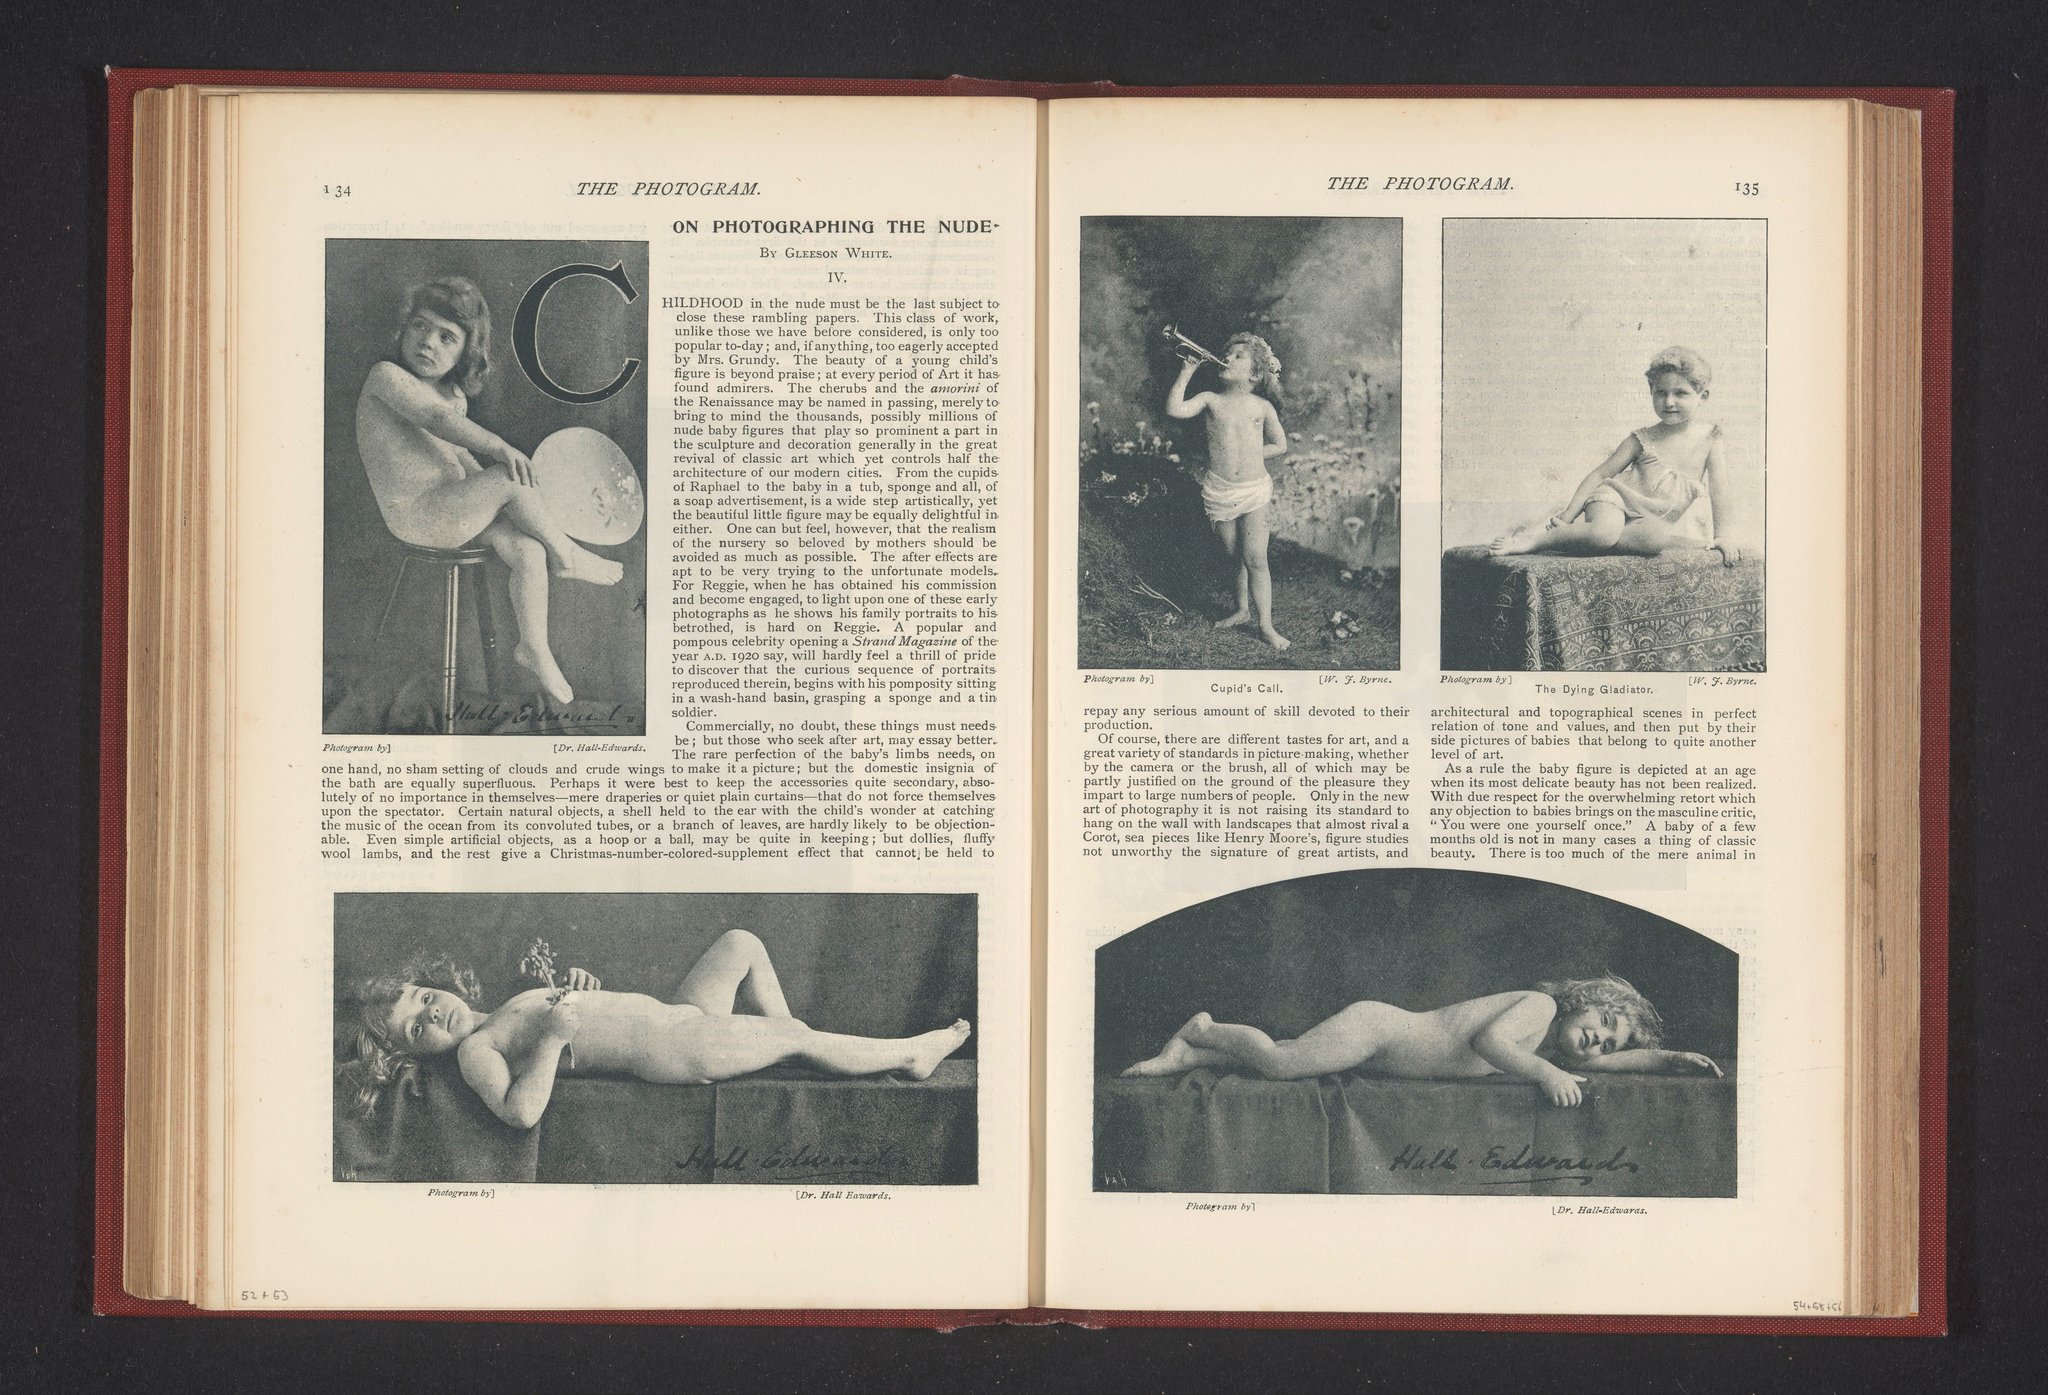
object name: photomechanical print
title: Portret van een onbekend meisje gezeten op een kleed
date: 1889-1894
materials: paper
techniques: autotype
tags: historical persons - bb - woman, girl (child between toddler and youth)